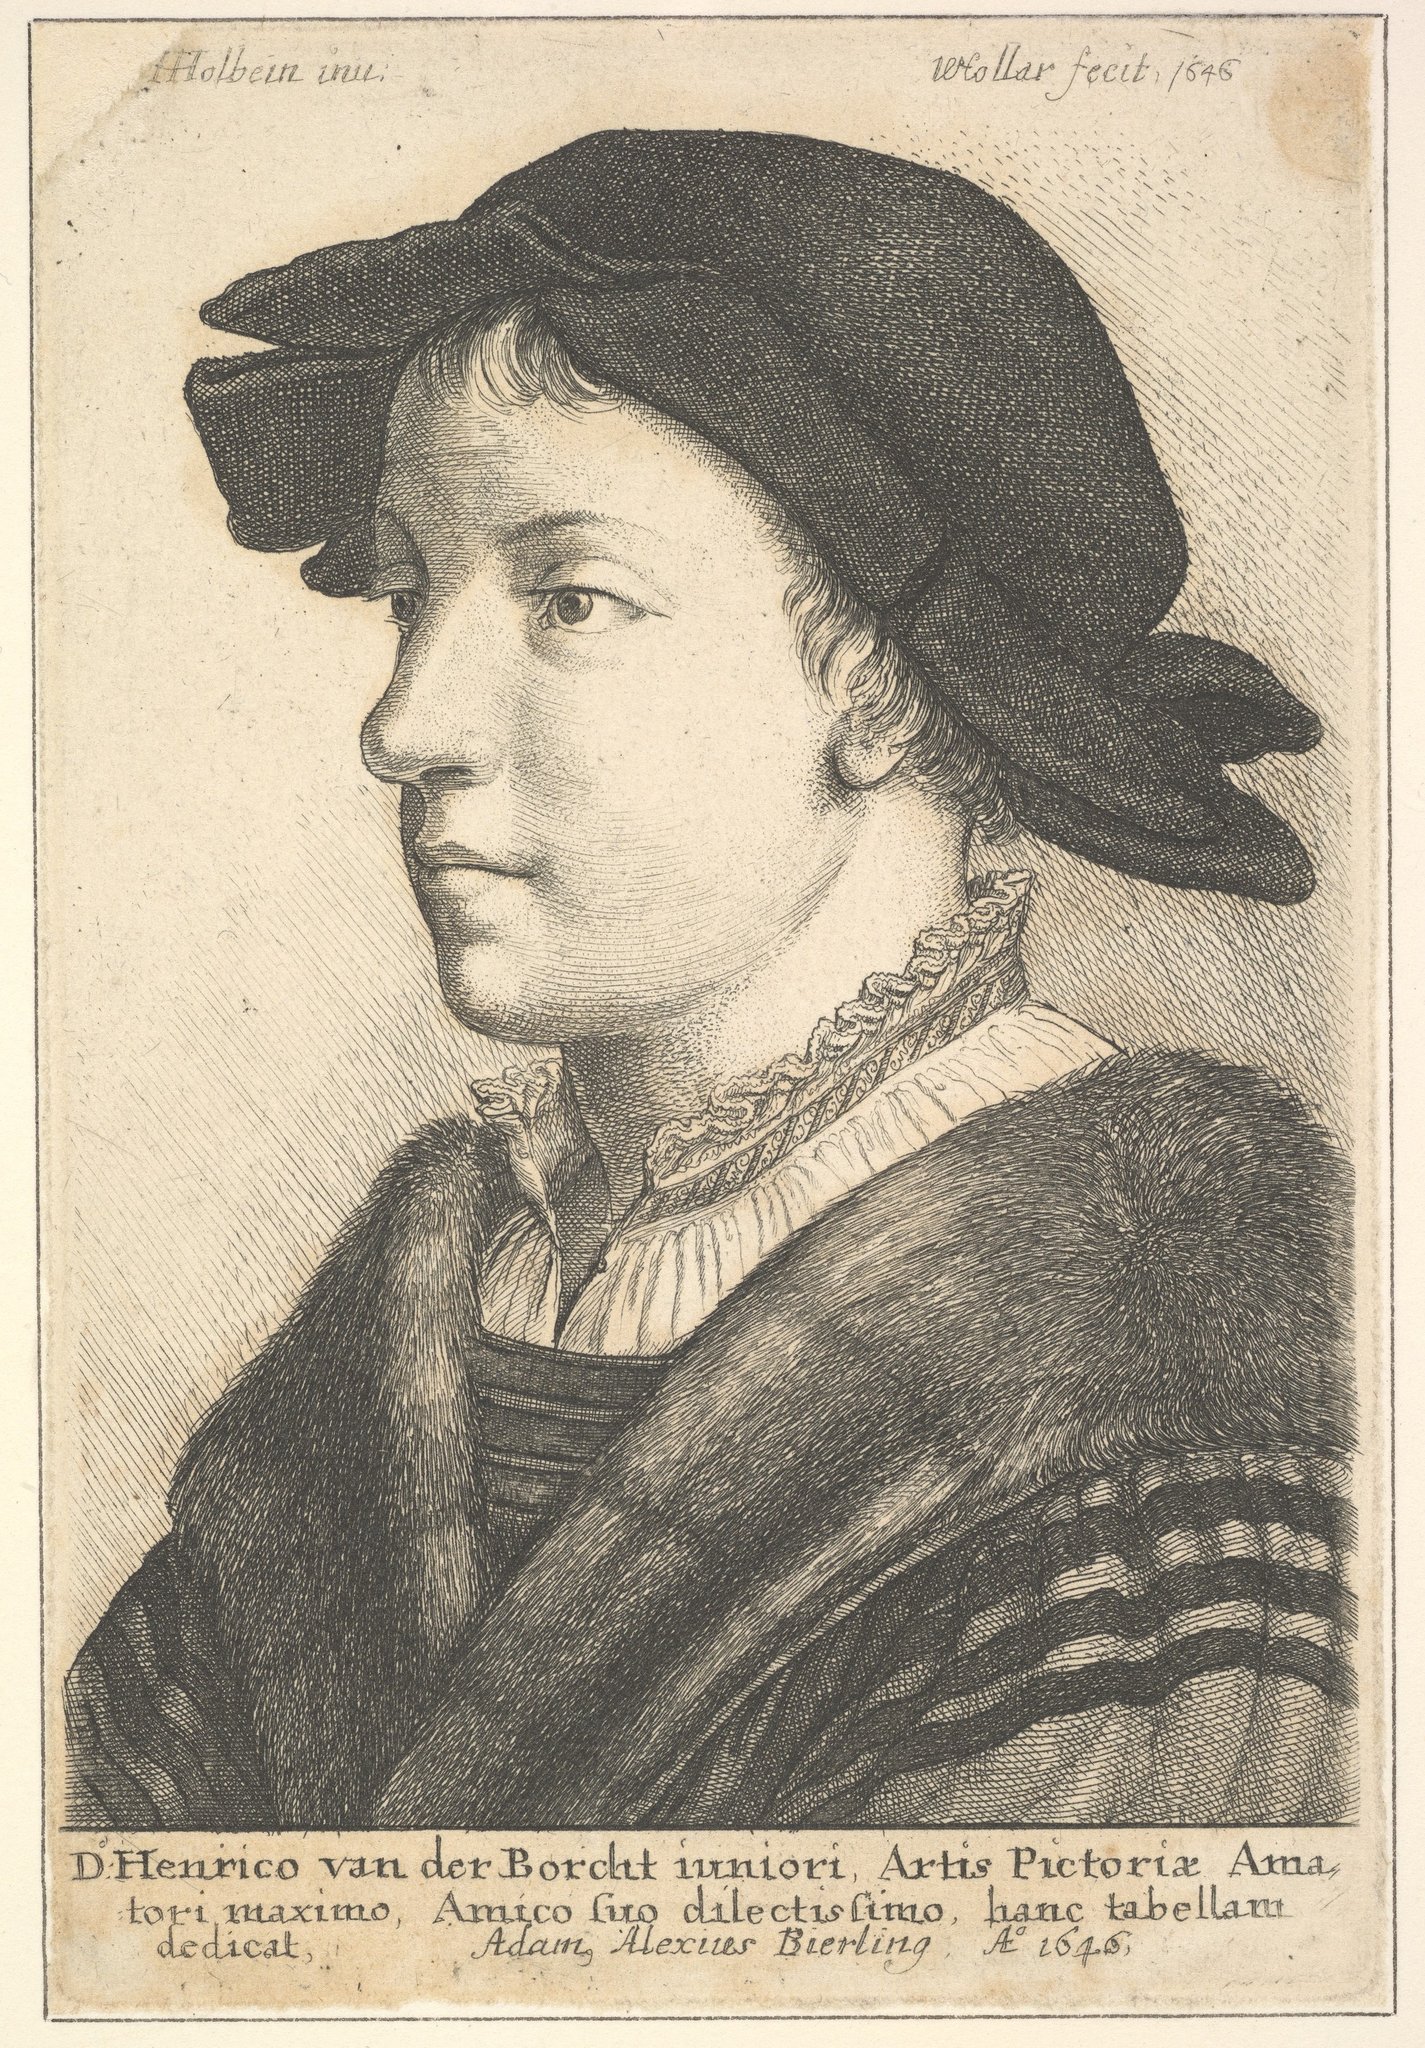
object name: print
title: Young man wearing a hat in profile to left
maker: wenceslaus hollar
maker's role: artist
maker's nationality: bohemian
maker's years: 1607-1677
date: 1646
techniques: etching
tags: hats,men,profiles